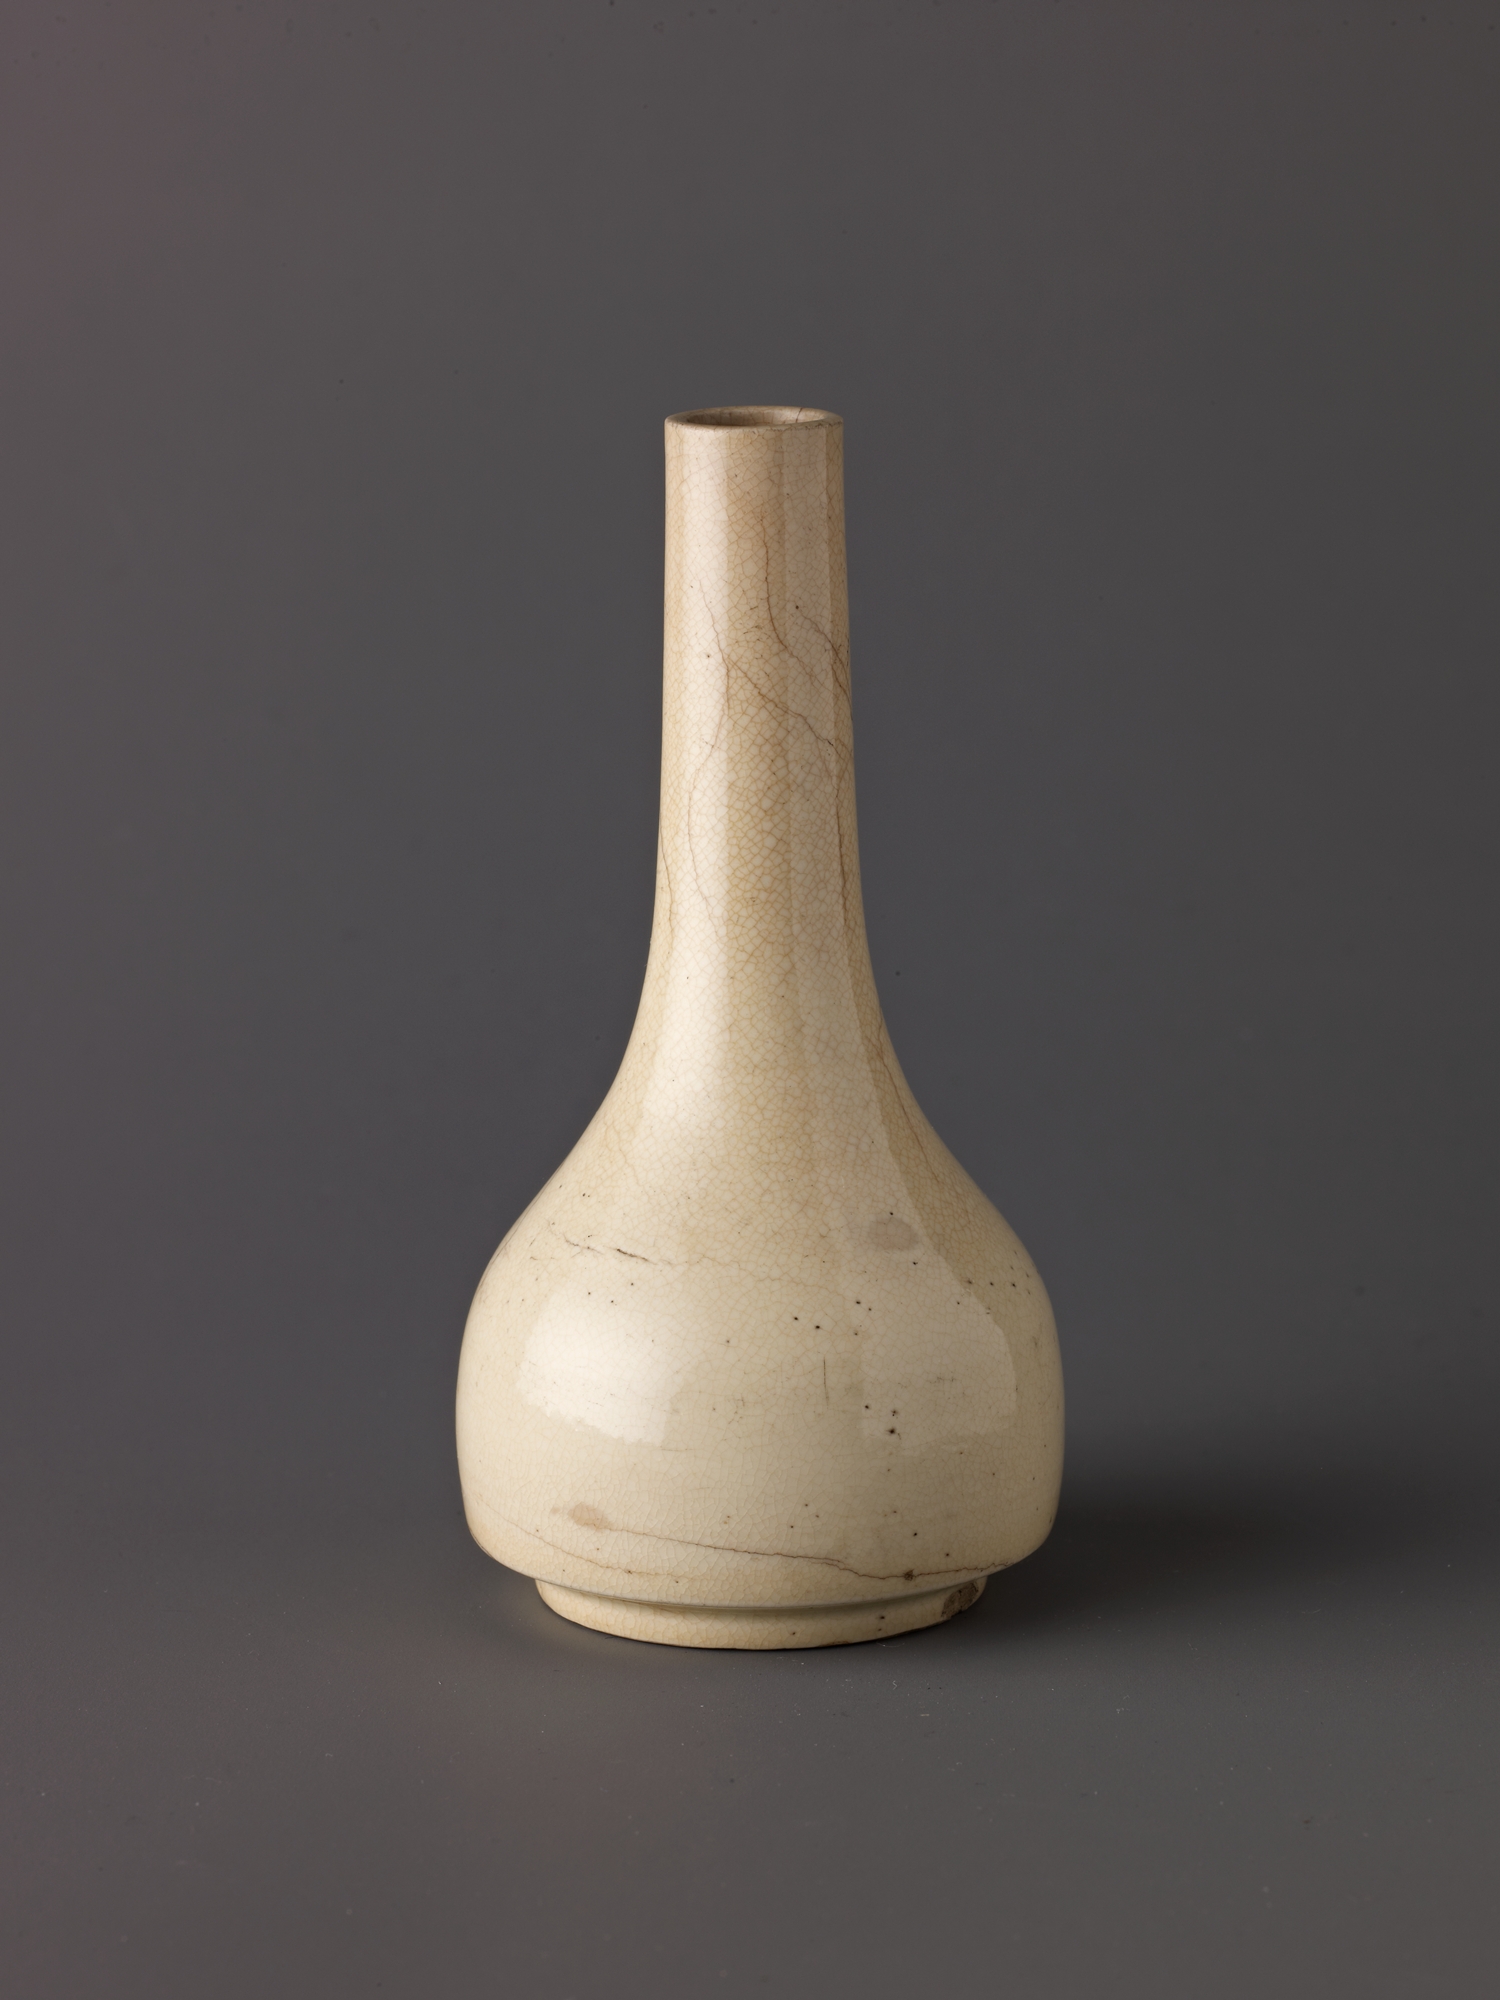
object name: vase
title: Small bottle-vase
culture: chinese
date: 1801-1900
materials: glaze, paste, porcelain